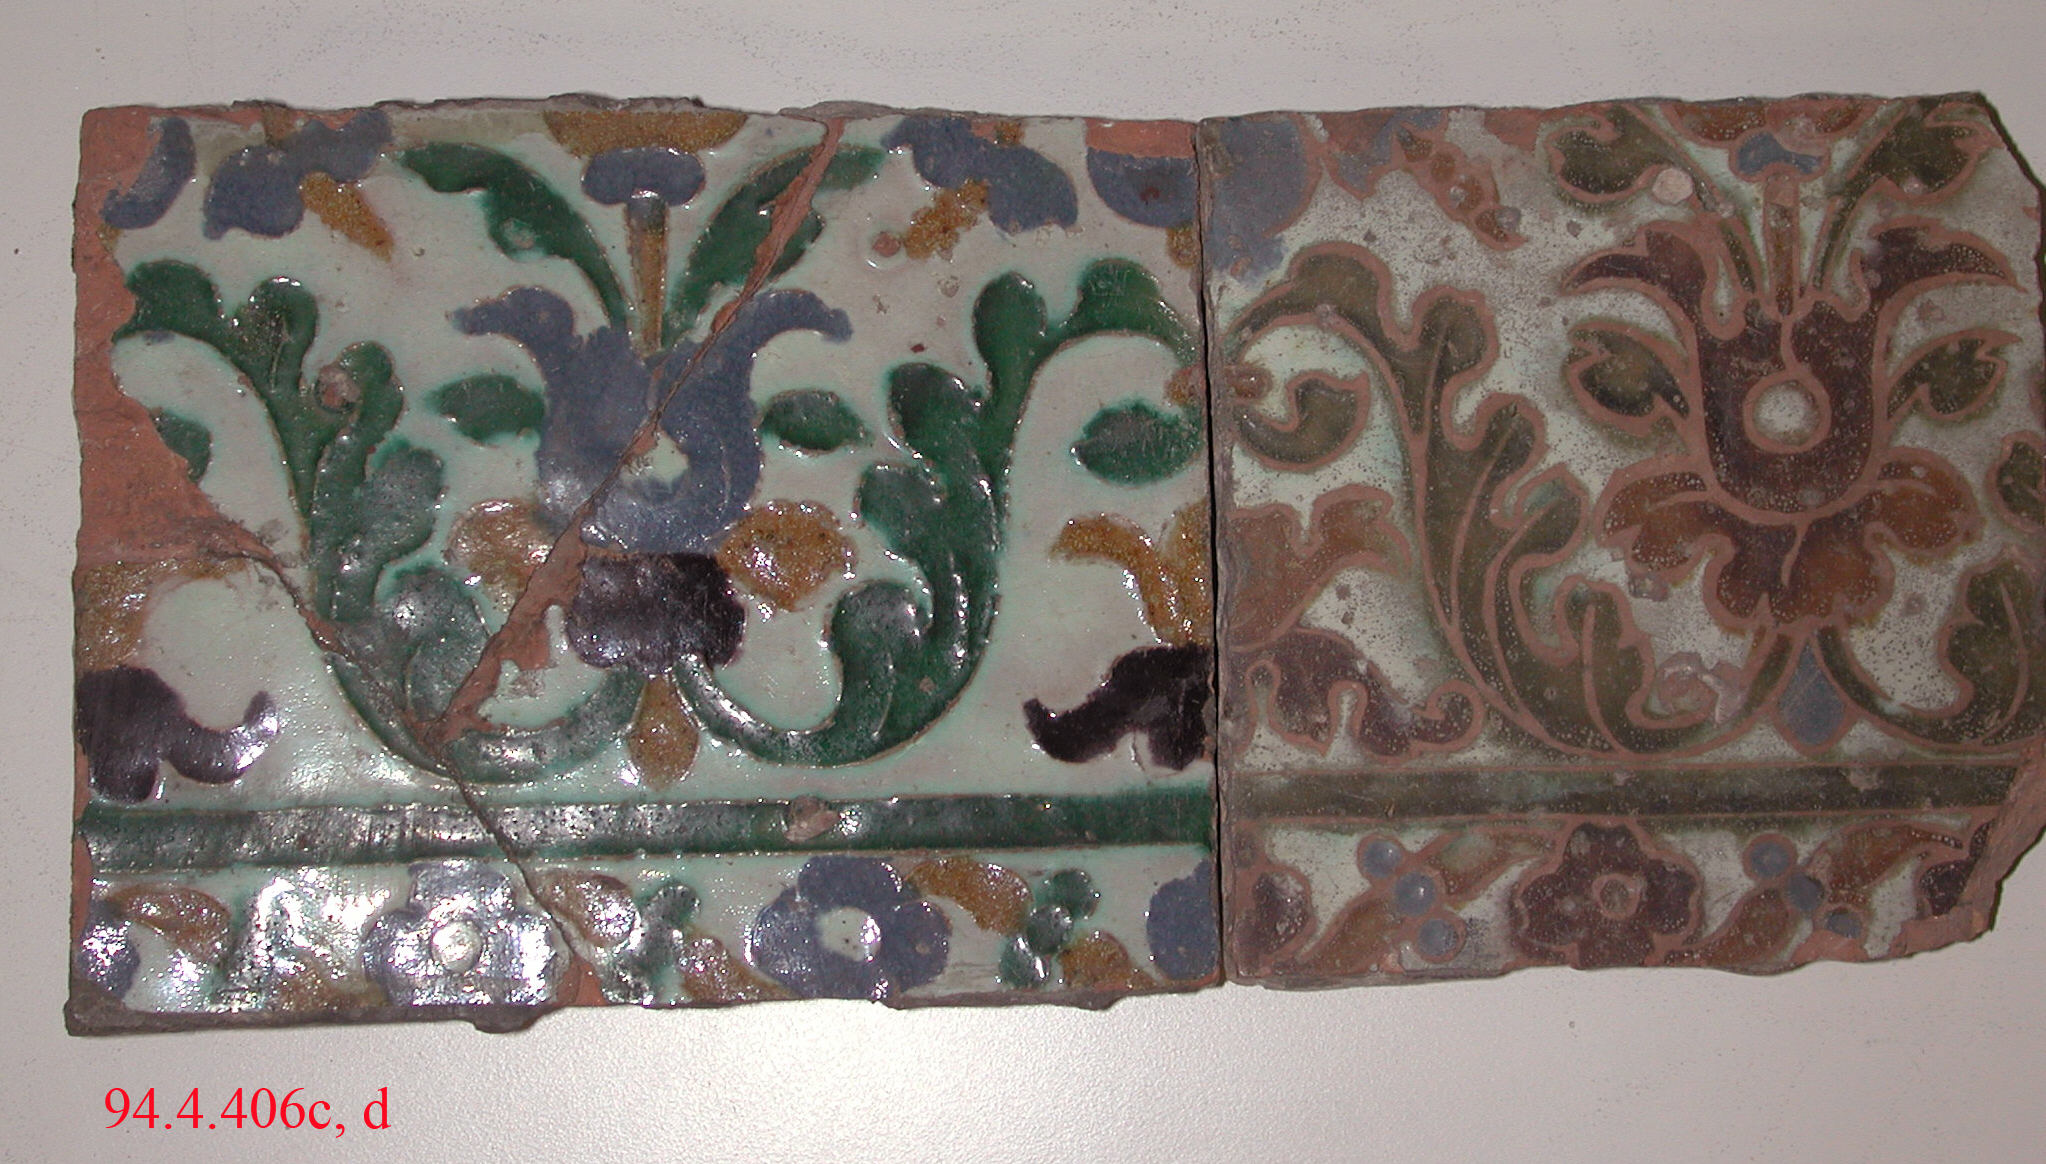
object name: tile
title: Tiles (5)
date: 1501-1700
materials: earthenware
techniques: glazing